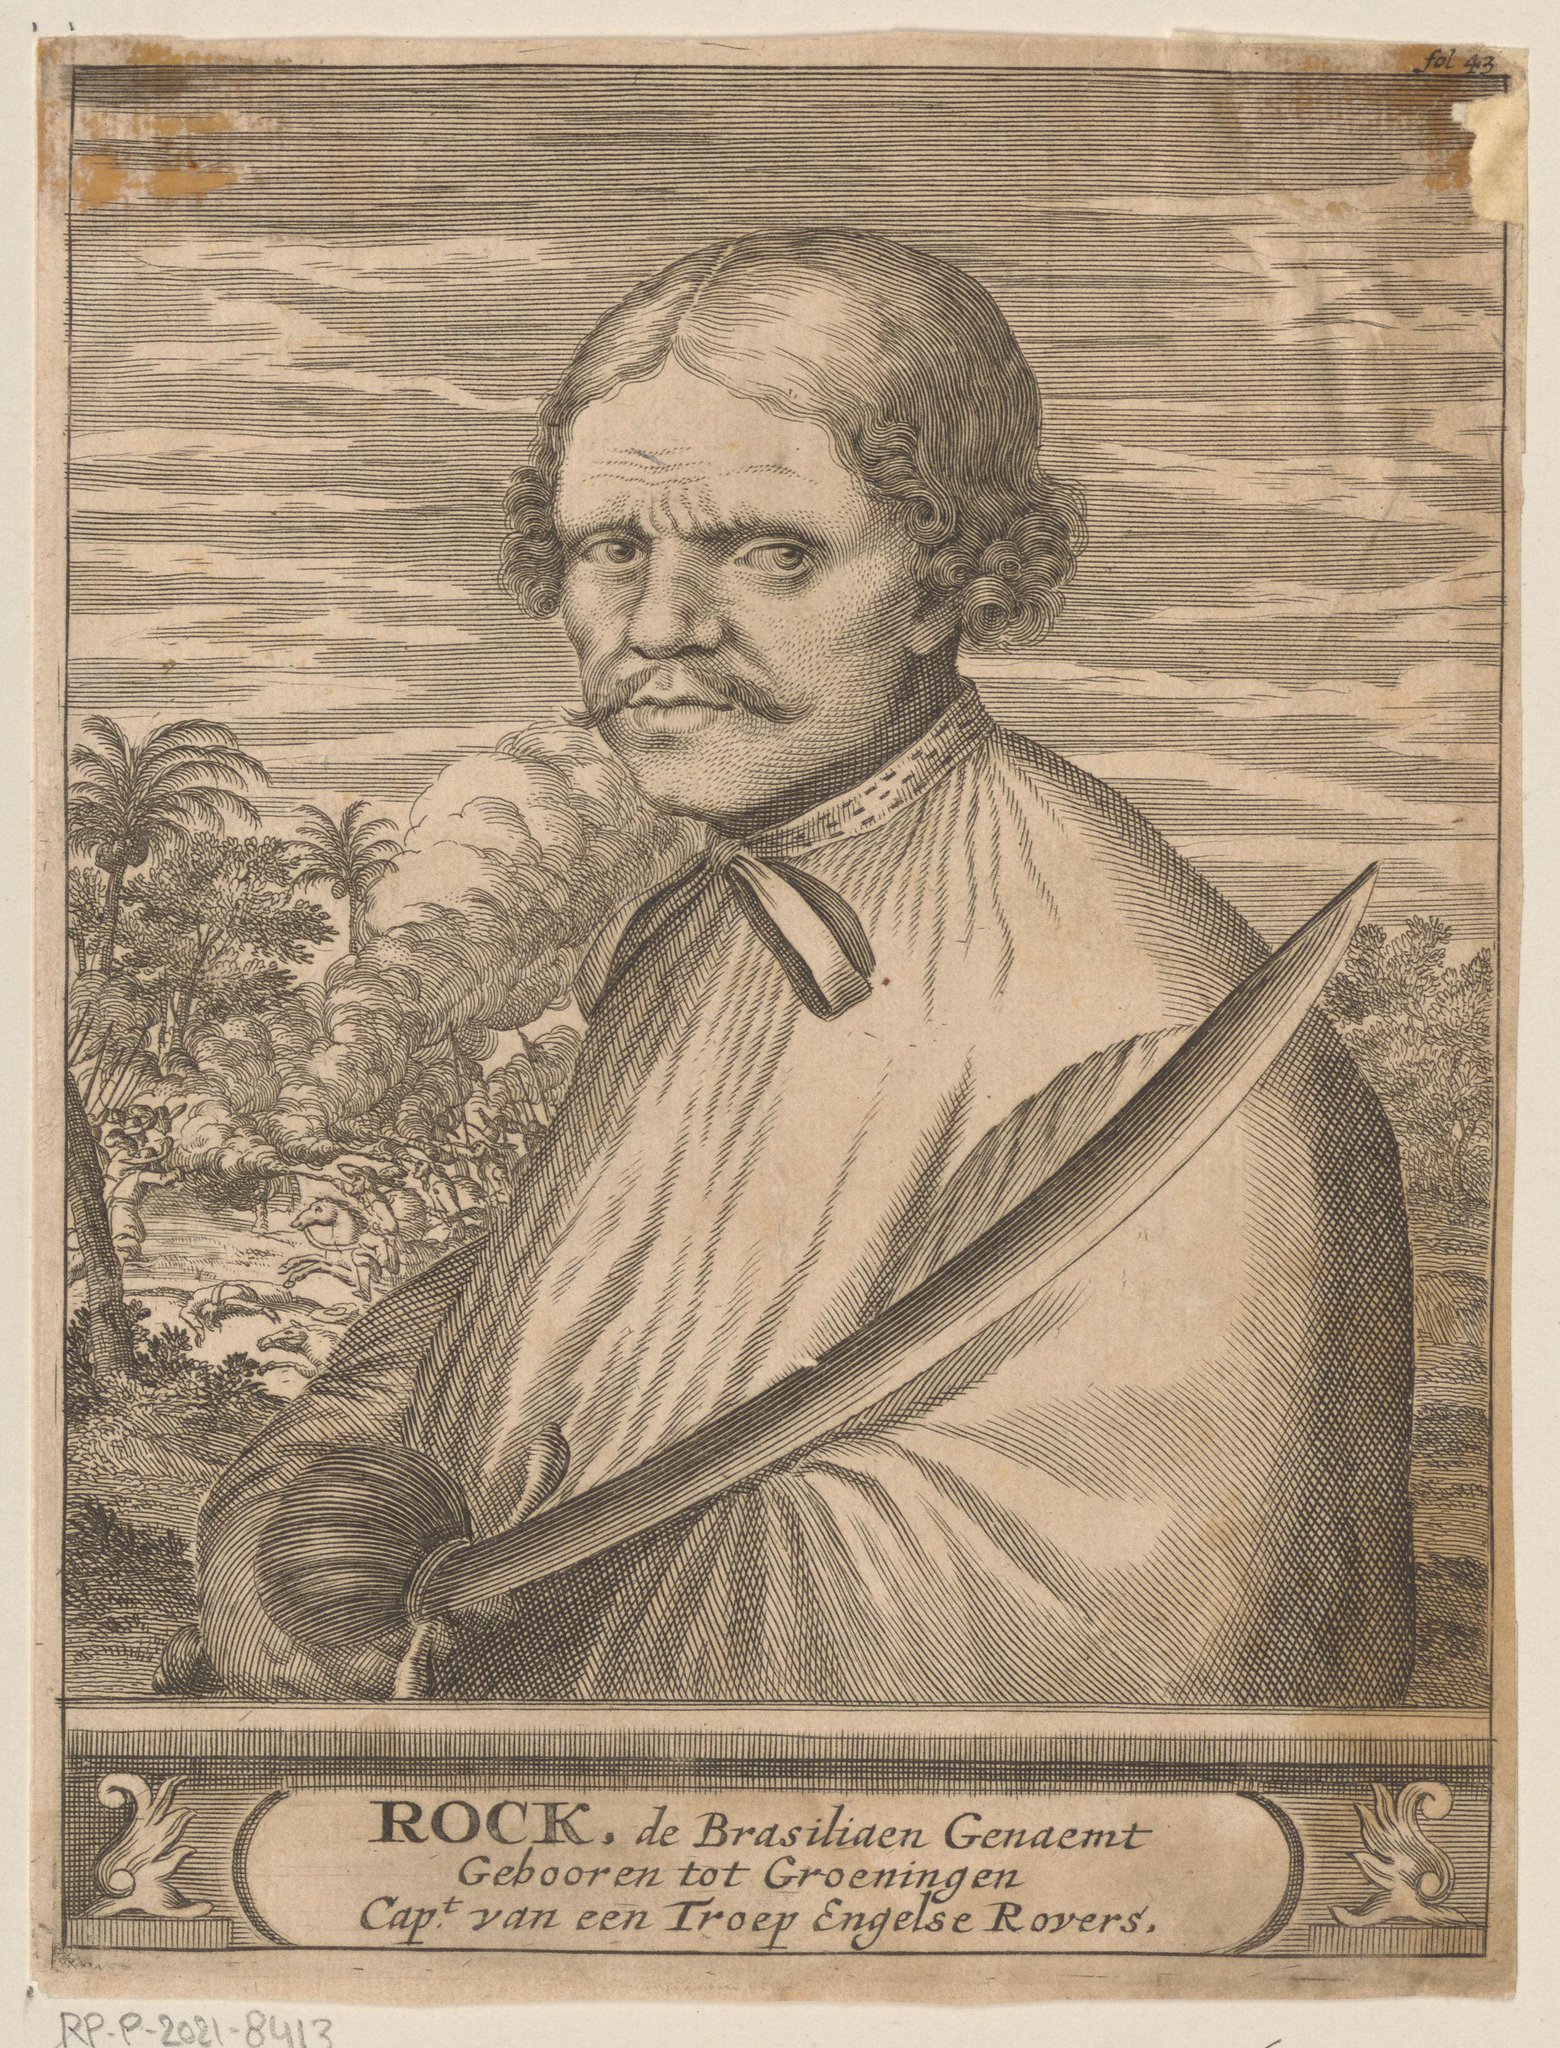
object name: print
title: Portret van Rock de Braziliaan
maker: herman padtbrugge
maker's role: print maker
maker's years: 1656-1687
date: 1678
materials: paper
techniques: engraving, etching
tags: groningen (province), historical persons, hacking and thrusting weapons: sword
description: Rechtsboven genummerd: fol. 43. Op de achtergrond wordt Rock de Braziliaan en zijn bemanning achtervolgd door Spaanse soldaten in de buurt van Campeche.